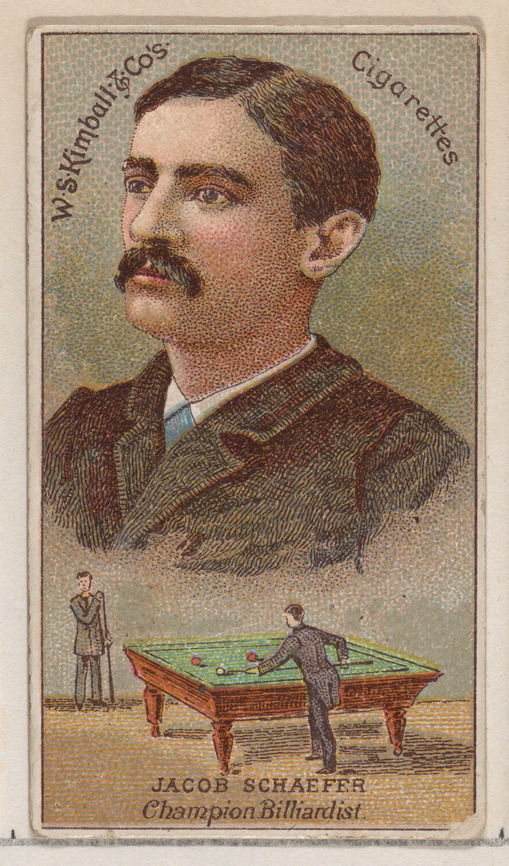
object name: print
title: Jacob Schaefer, Champion Billiardist, from the Champions of Games and Sports series (N184, Type 1) issued by W.S. Kimball & Co.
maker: w.s. kimball & co.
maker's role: publisher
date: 1887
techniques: color lithograph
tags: men